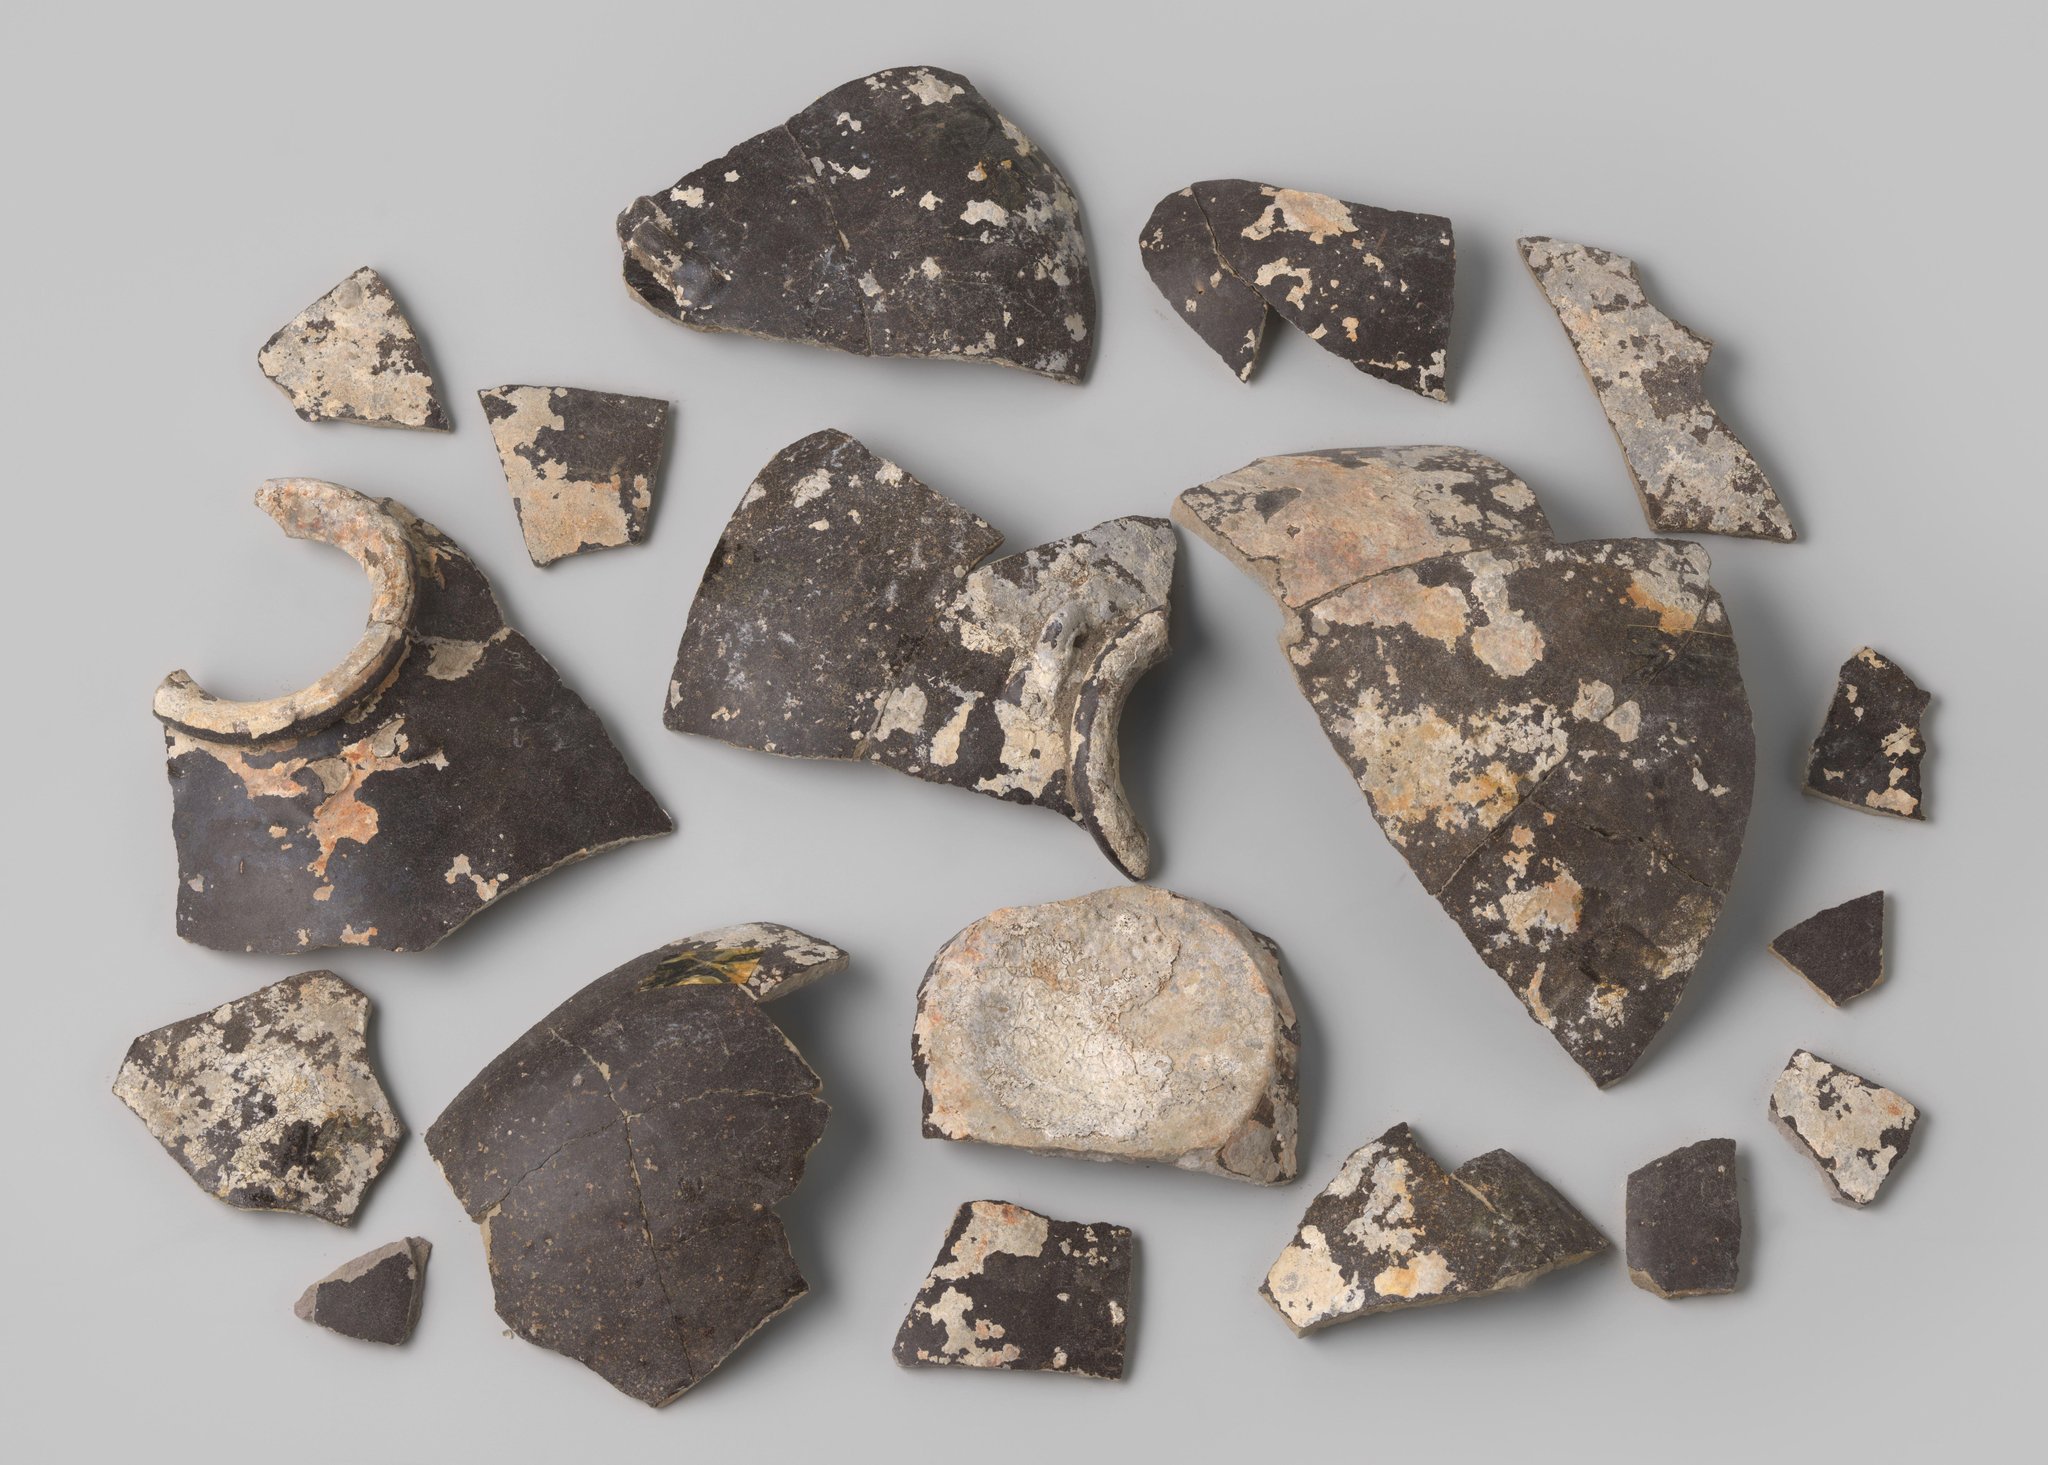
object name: sherd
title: Scherven van martavanen uit V.O.C.-schip de 'Witte Leeuw'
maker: Anonymous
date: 1613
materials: porcelain, stoneware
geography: south china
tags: verenigde oostindische compagnie, sint-helena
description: A jar. The grey body has black specks. The exterior is covered with a sepia coloured glaze. The interior is enturely covered with a greenish brown glaze. There was probably a mark between the ears. Lip-rim, shoulder and waist are damaged due to other objects having been placed on or against the jar. A similar type of jar was found in the wreck of the San Antionio, sunk in 1697.